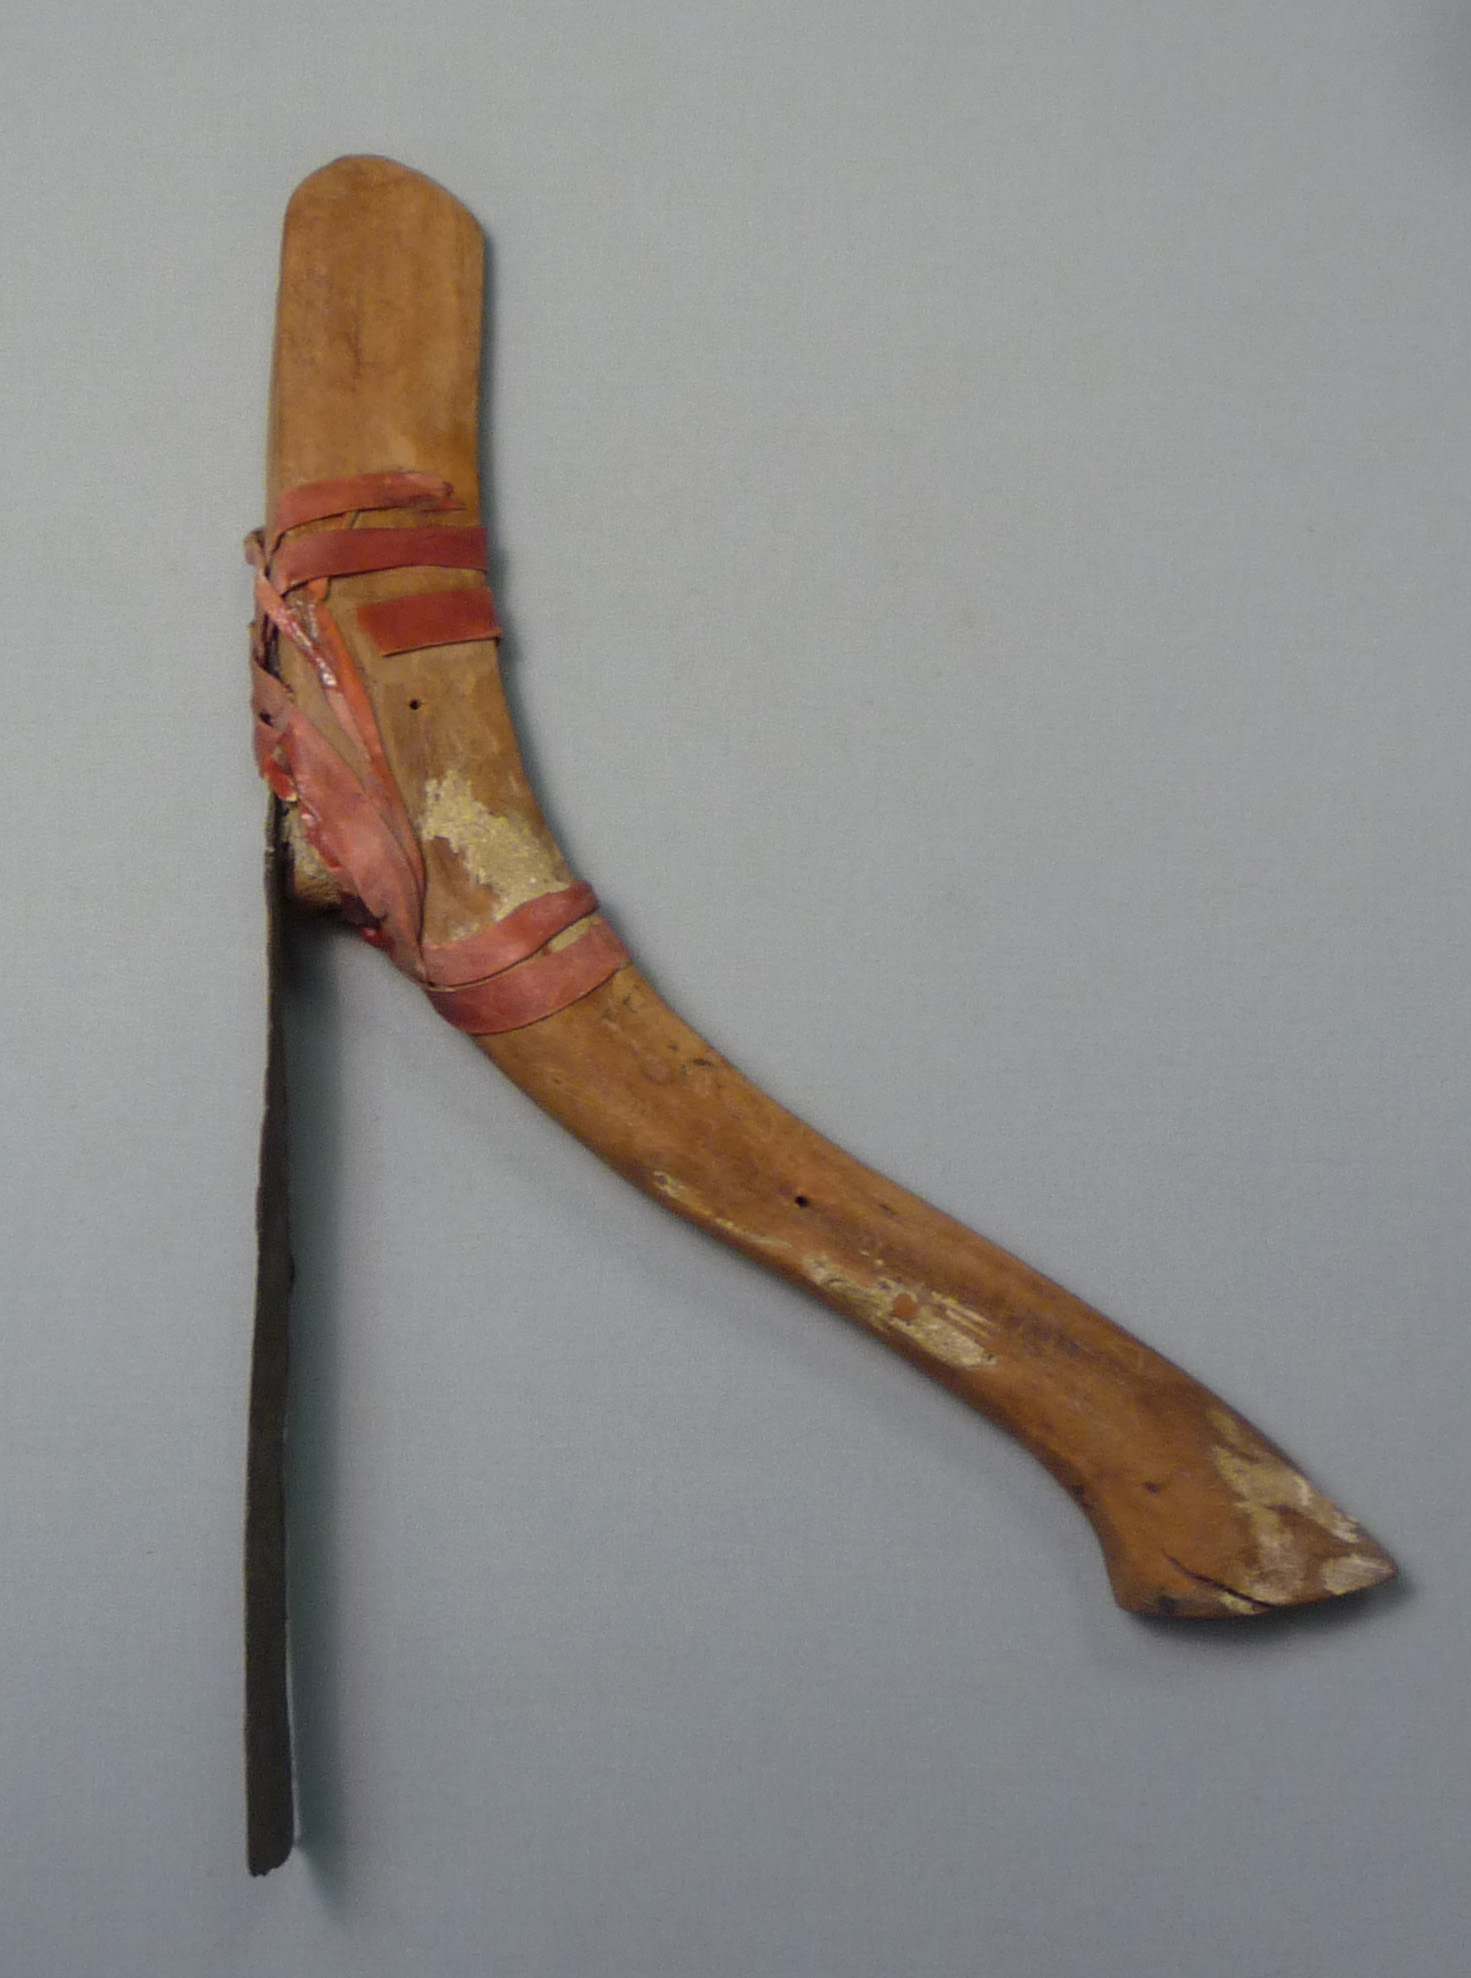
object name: adze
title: Inscribed Adze From Foundation Deposit 2 of Hatshepsut's Valley Temple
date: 1479-1458 BCE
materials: bronze, copper alloy, leather, wood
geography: egypt